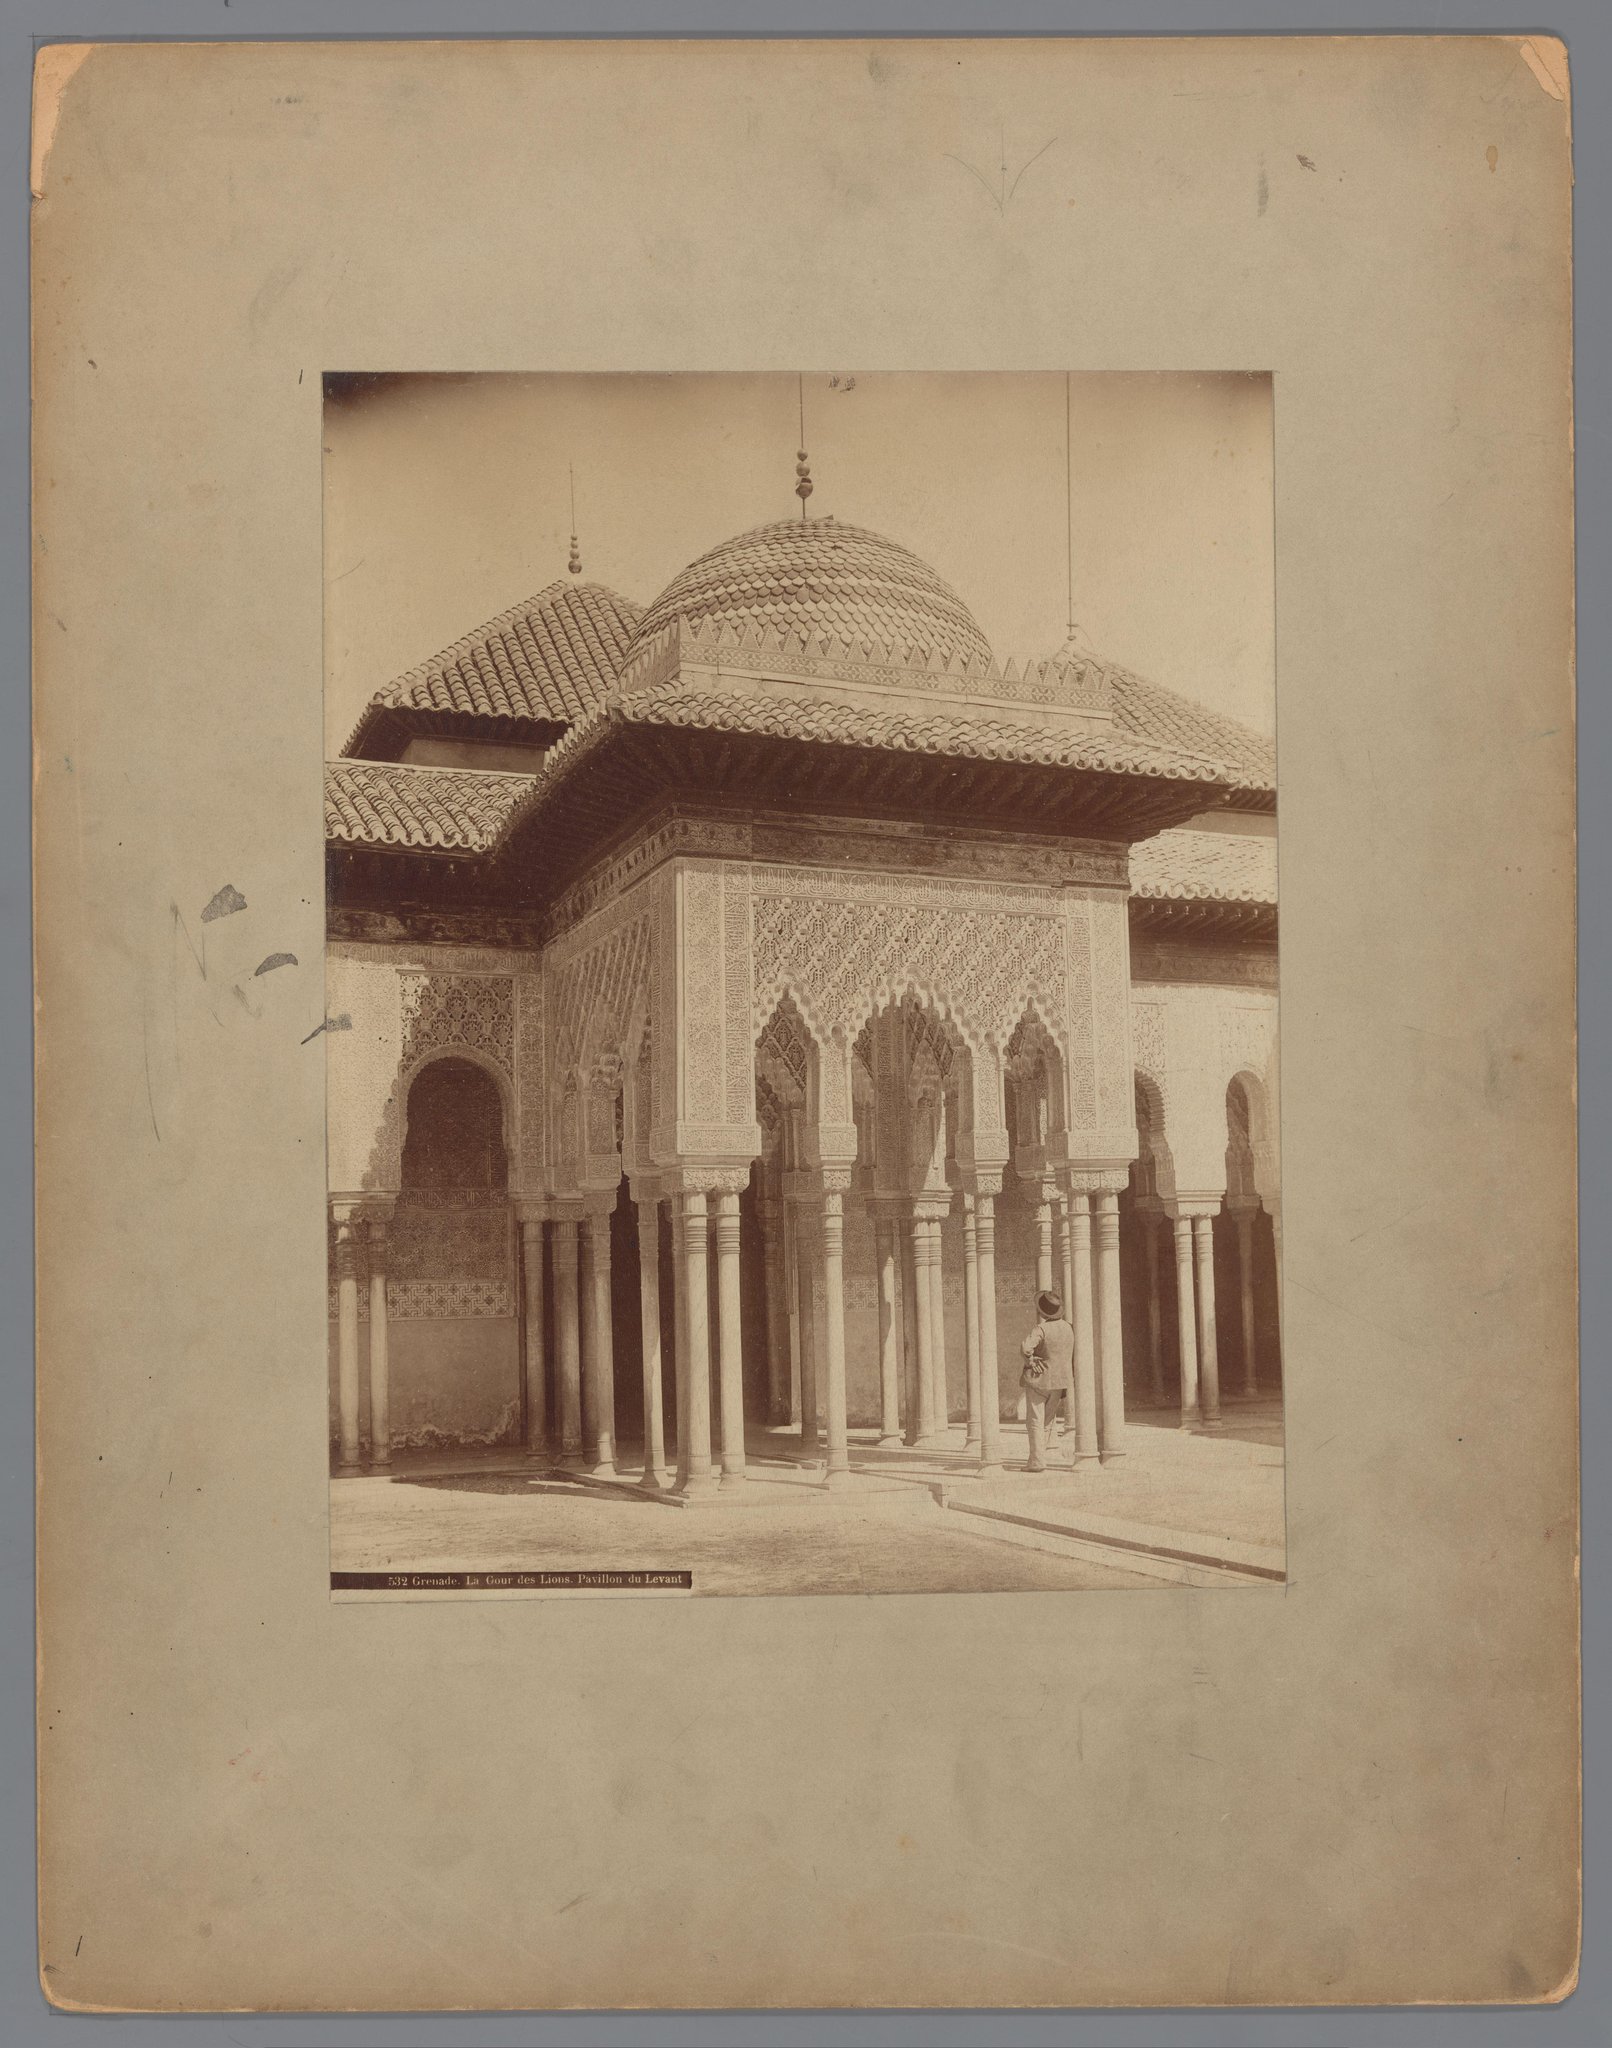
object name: photograph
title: Grenade. La cour des Lions. Pavillon du Levant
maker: Anonymous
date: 1875-1900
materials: cardboard, photographic support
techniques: albumen print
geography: alhambra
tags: fortress, column, pillar ~ architecture, flat decoration ~ applied arts (+ islamic art), façade (of house or building)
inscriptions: collector's mark: Lugt 3937, number: ‘532’, inscription: ‘Syrië’